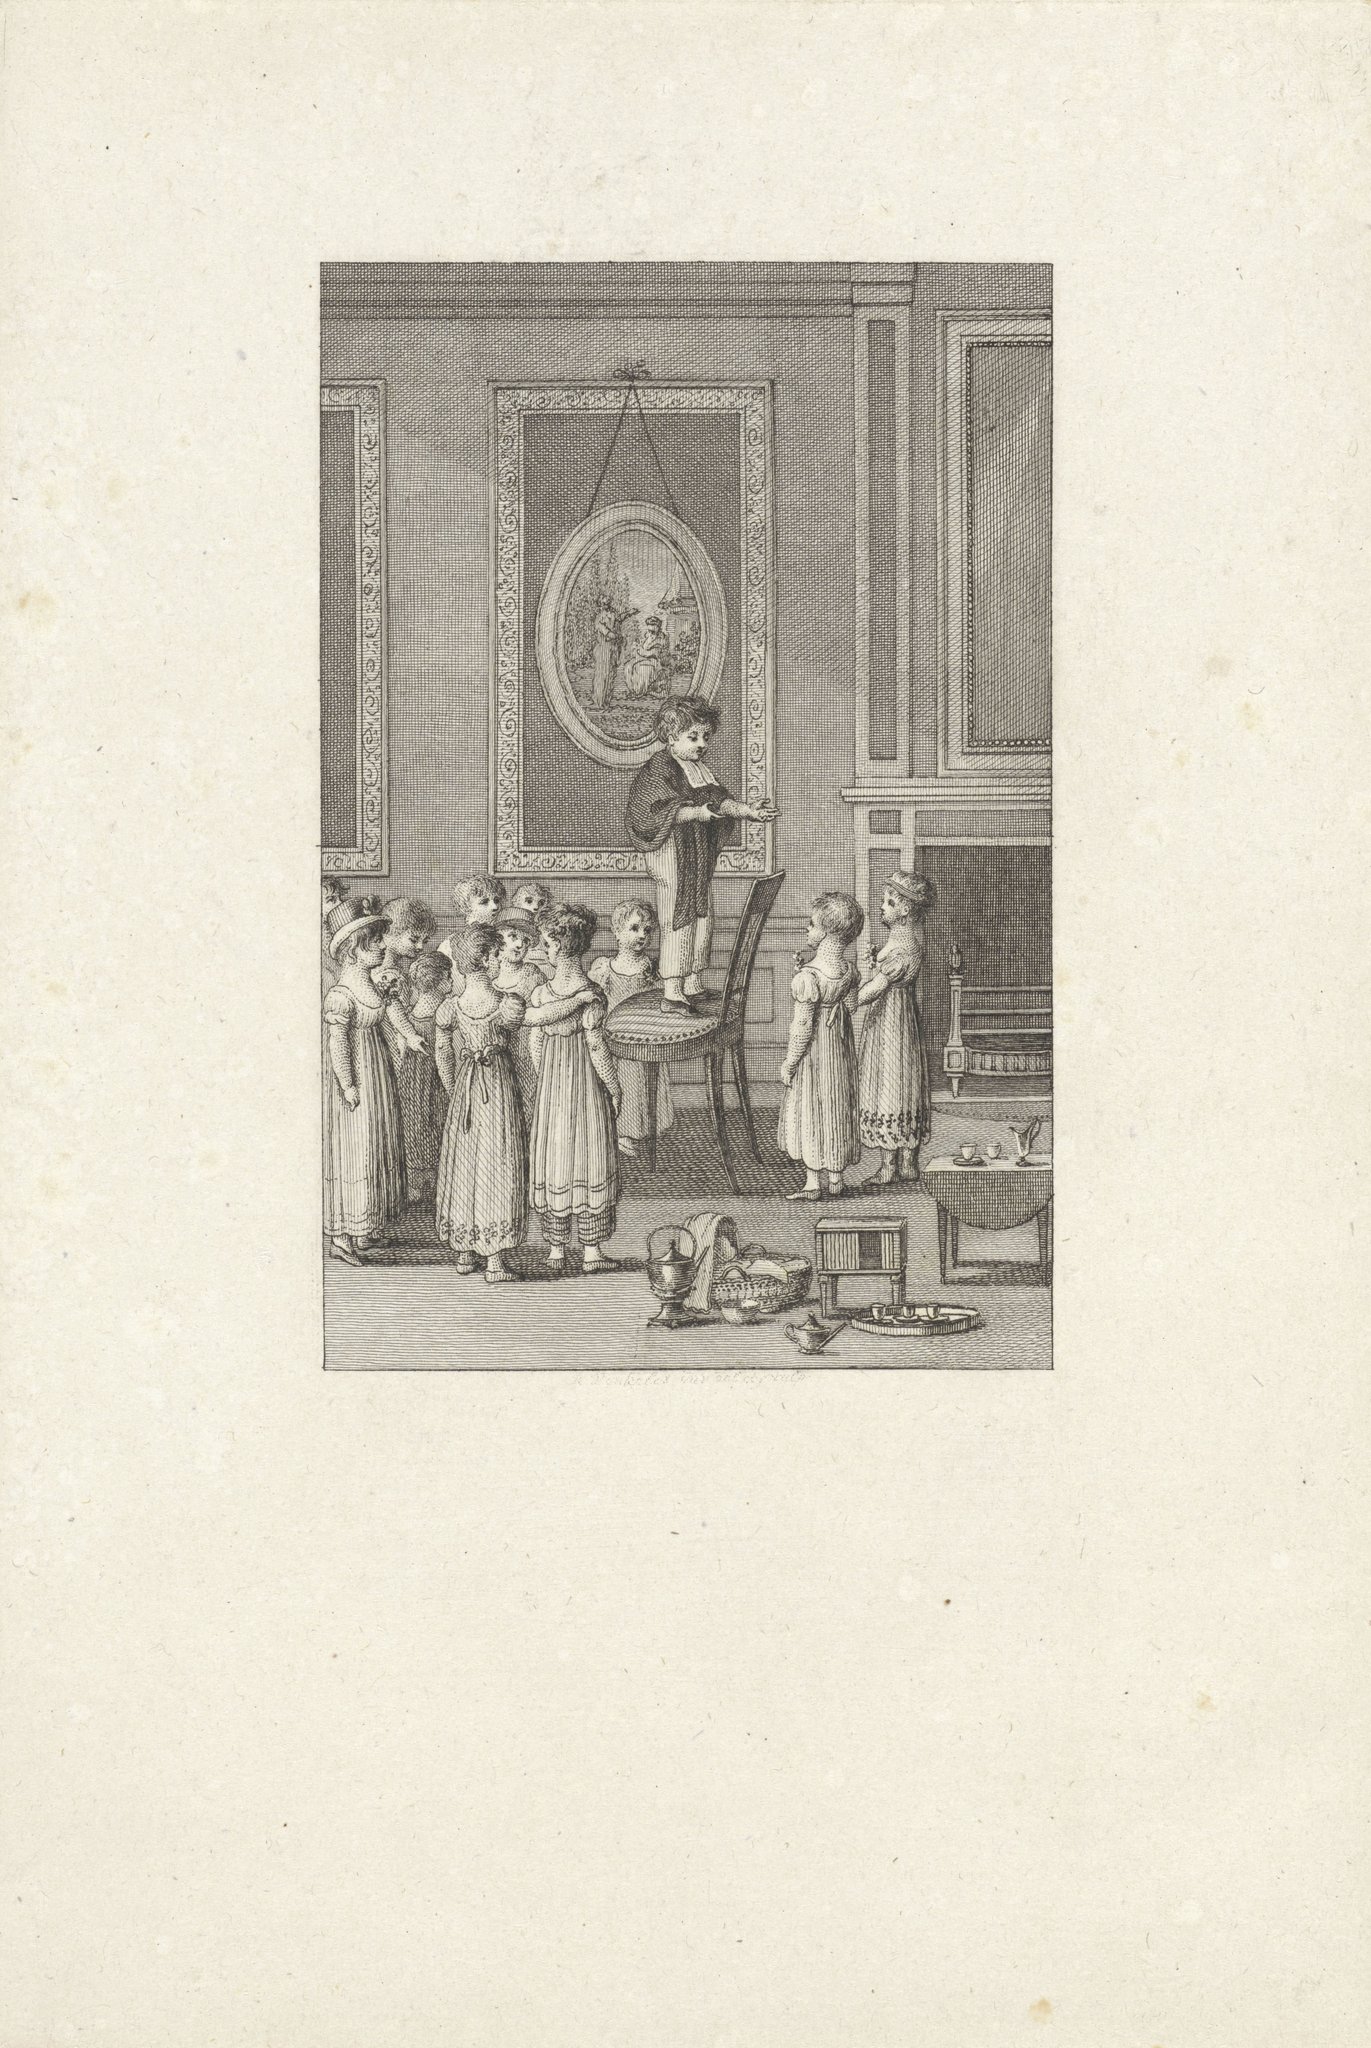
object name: print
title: Jongen op een stoel omringd door meisjes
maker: reinier vinkeles (i)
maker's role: draughtsman, print maker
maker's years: 1741-1816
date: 1809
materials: paper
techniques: engraving, etching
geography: amsterdam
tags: human life divided into stages, e.g. three, four, seven, twelve stages (with number), growing up - aa - girl, preaching (in general)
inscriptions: collector's mark: Lugt 2228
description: Interieur met jonge meisjes die zich om een jongen met een priestergewaad op een stoel hebben gepositioneerd. De prent is een illustratie voor een boek over de vier 'tijdperken' van de vrouw, van het tijdperk 'het meisje'.